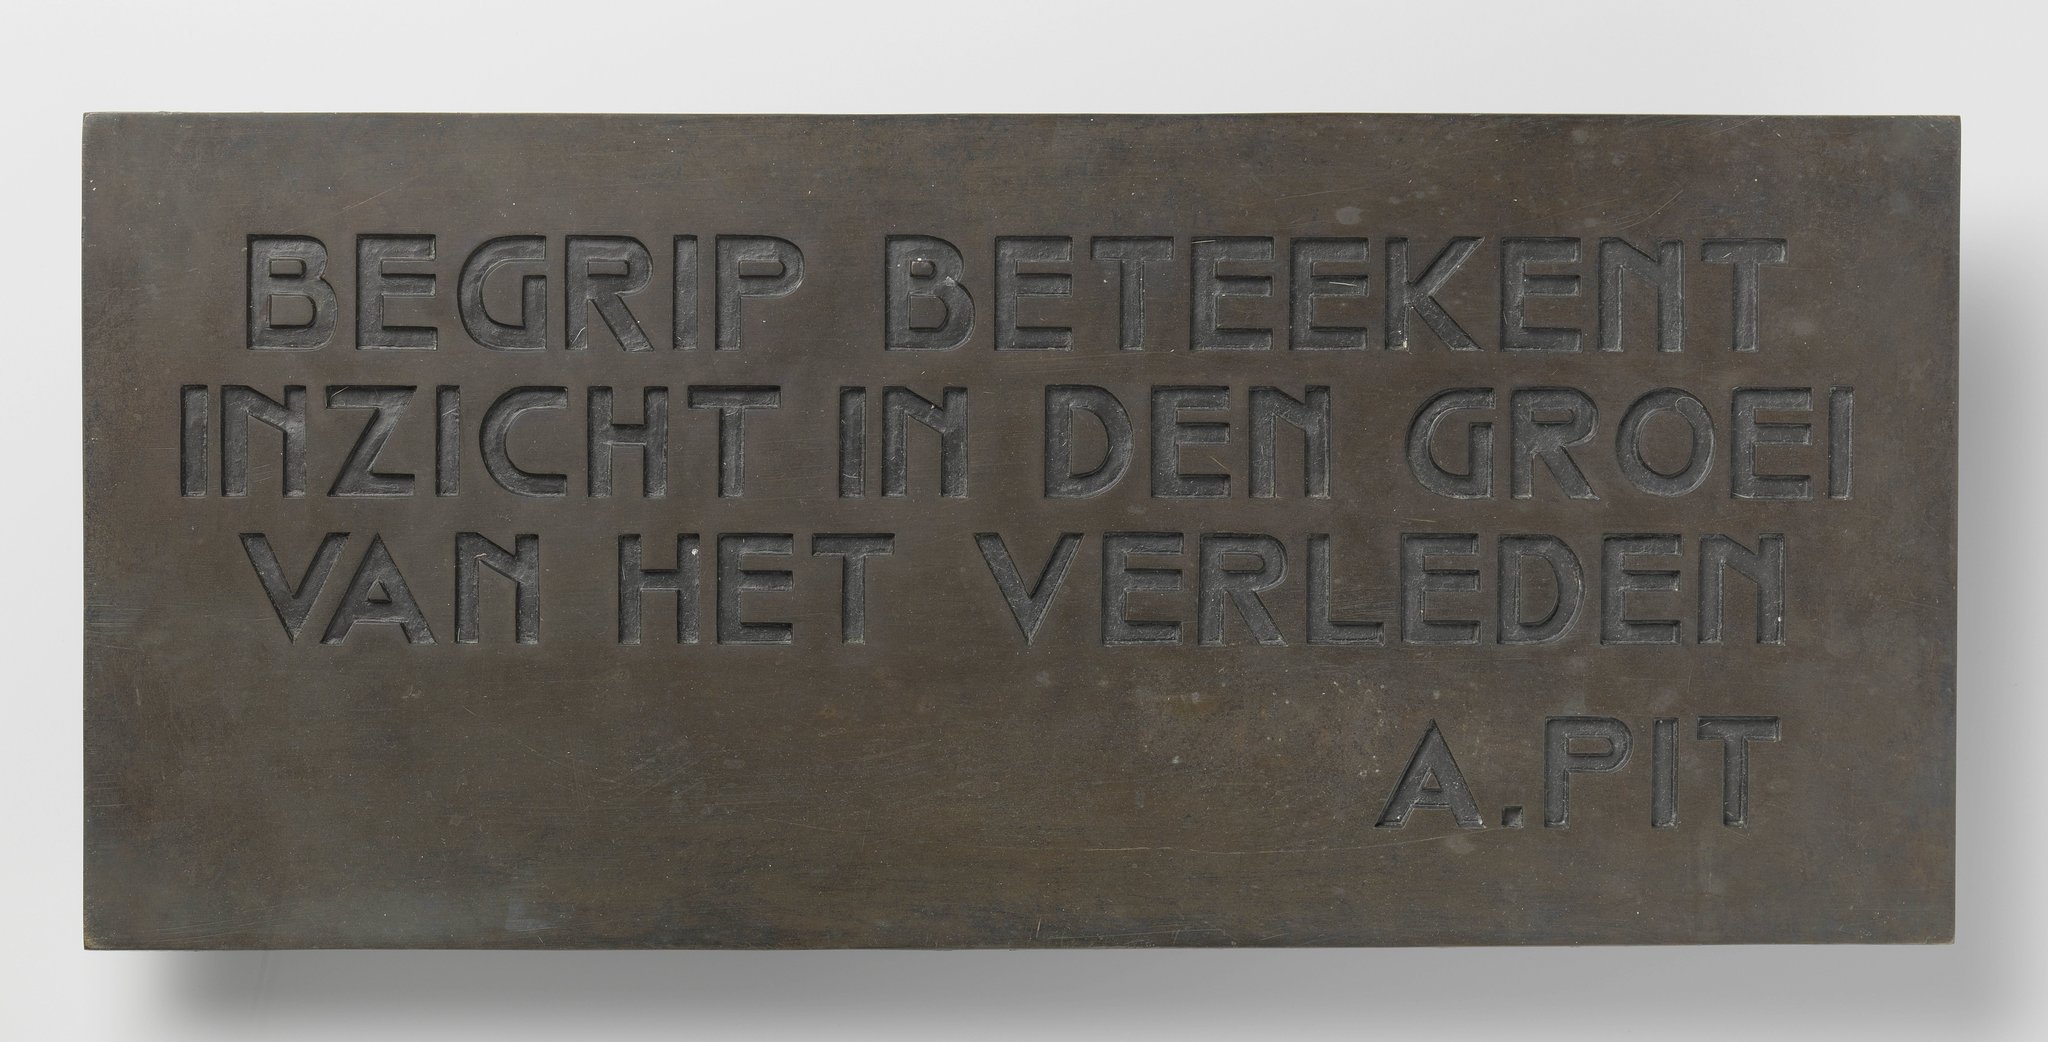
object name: plate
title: Plaat behorend bij het borstbeeld van Dr. A. Pit (1860-1944), directeur van het Ned. Museum voor Geschiedenis en Kunst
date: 1925-1975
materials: bronze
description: Plaat behorend bij het borstbeeld van Dr. A. Pit (1860-1944), directeur van het Ned. Museum voor Geschiedenis en Kunst. De tekst op de plaat luidt: Begrip beteekent inzicht in den groei van het verleden A.Pit.